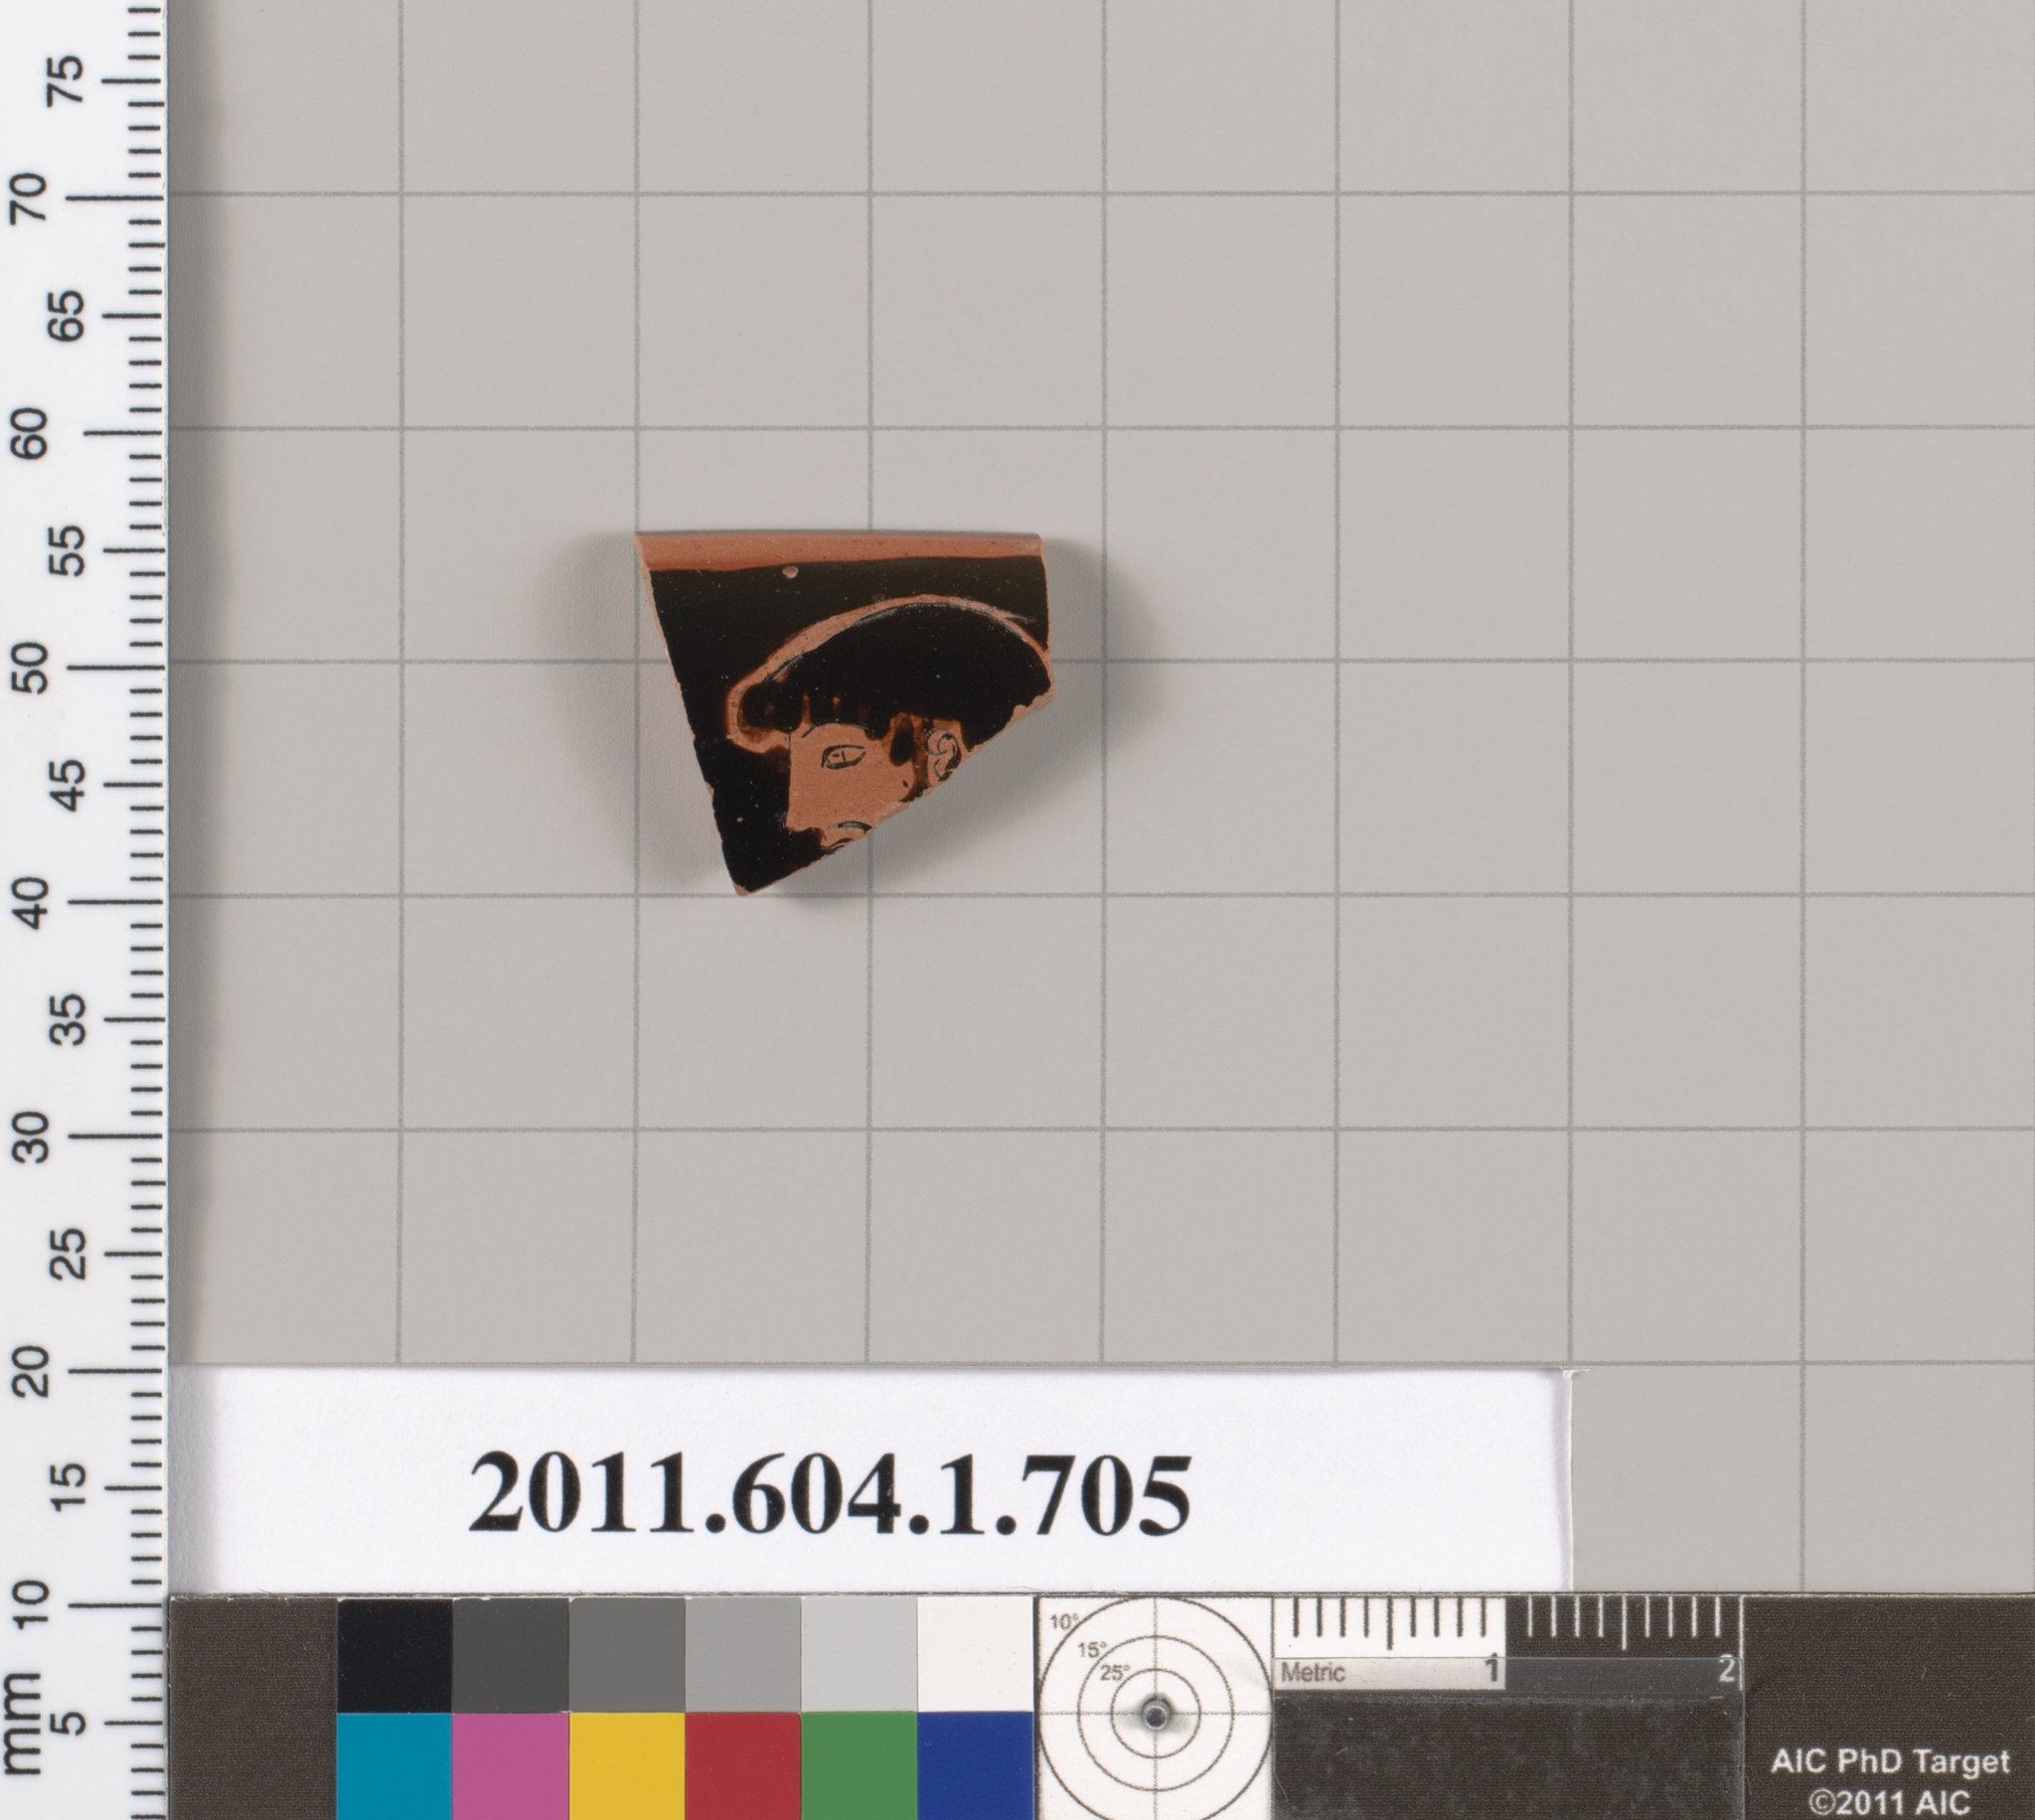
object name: kylix fragment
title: Terracotta rim fragment of a kylix (drinking cup)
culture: greek, attic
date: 490-480 BCE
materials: terracotta